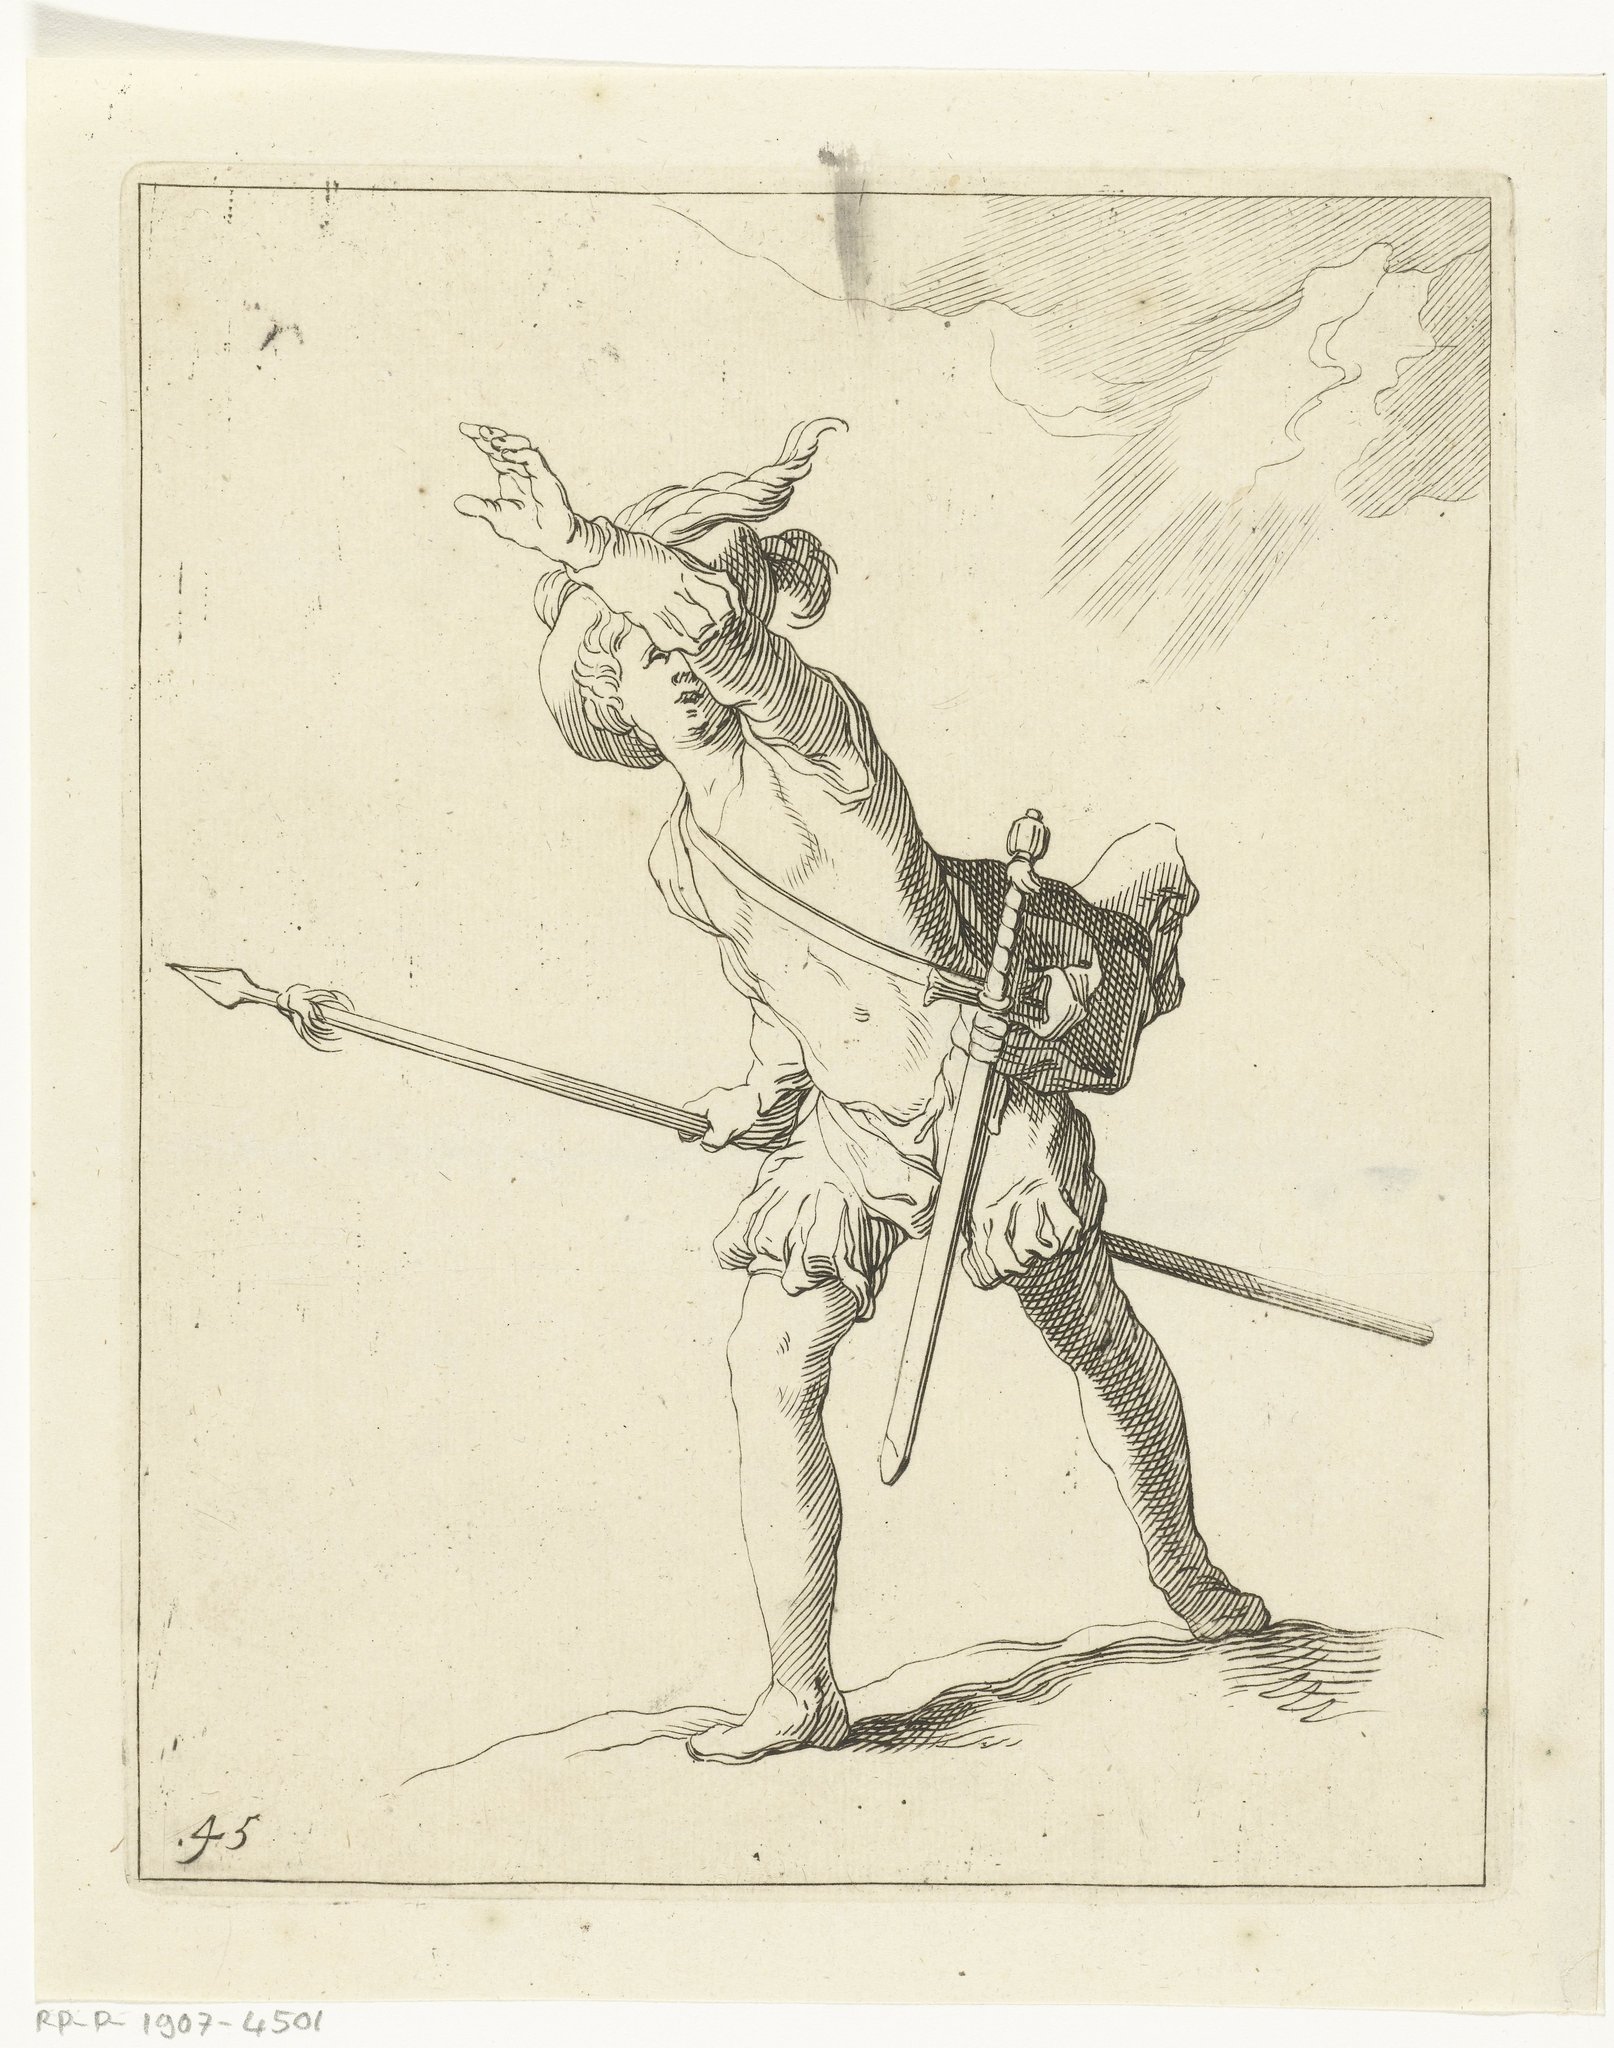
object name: print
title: Het tekenboek van Abraham Bloemaert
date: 1679-1701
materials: paper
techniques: etching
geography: amsterdam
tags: the soldier; the soldier's life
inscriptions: collector's mark: Lugt 2228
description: Hetzelfde watermerk als een titelpagina uit de Visscher editie.